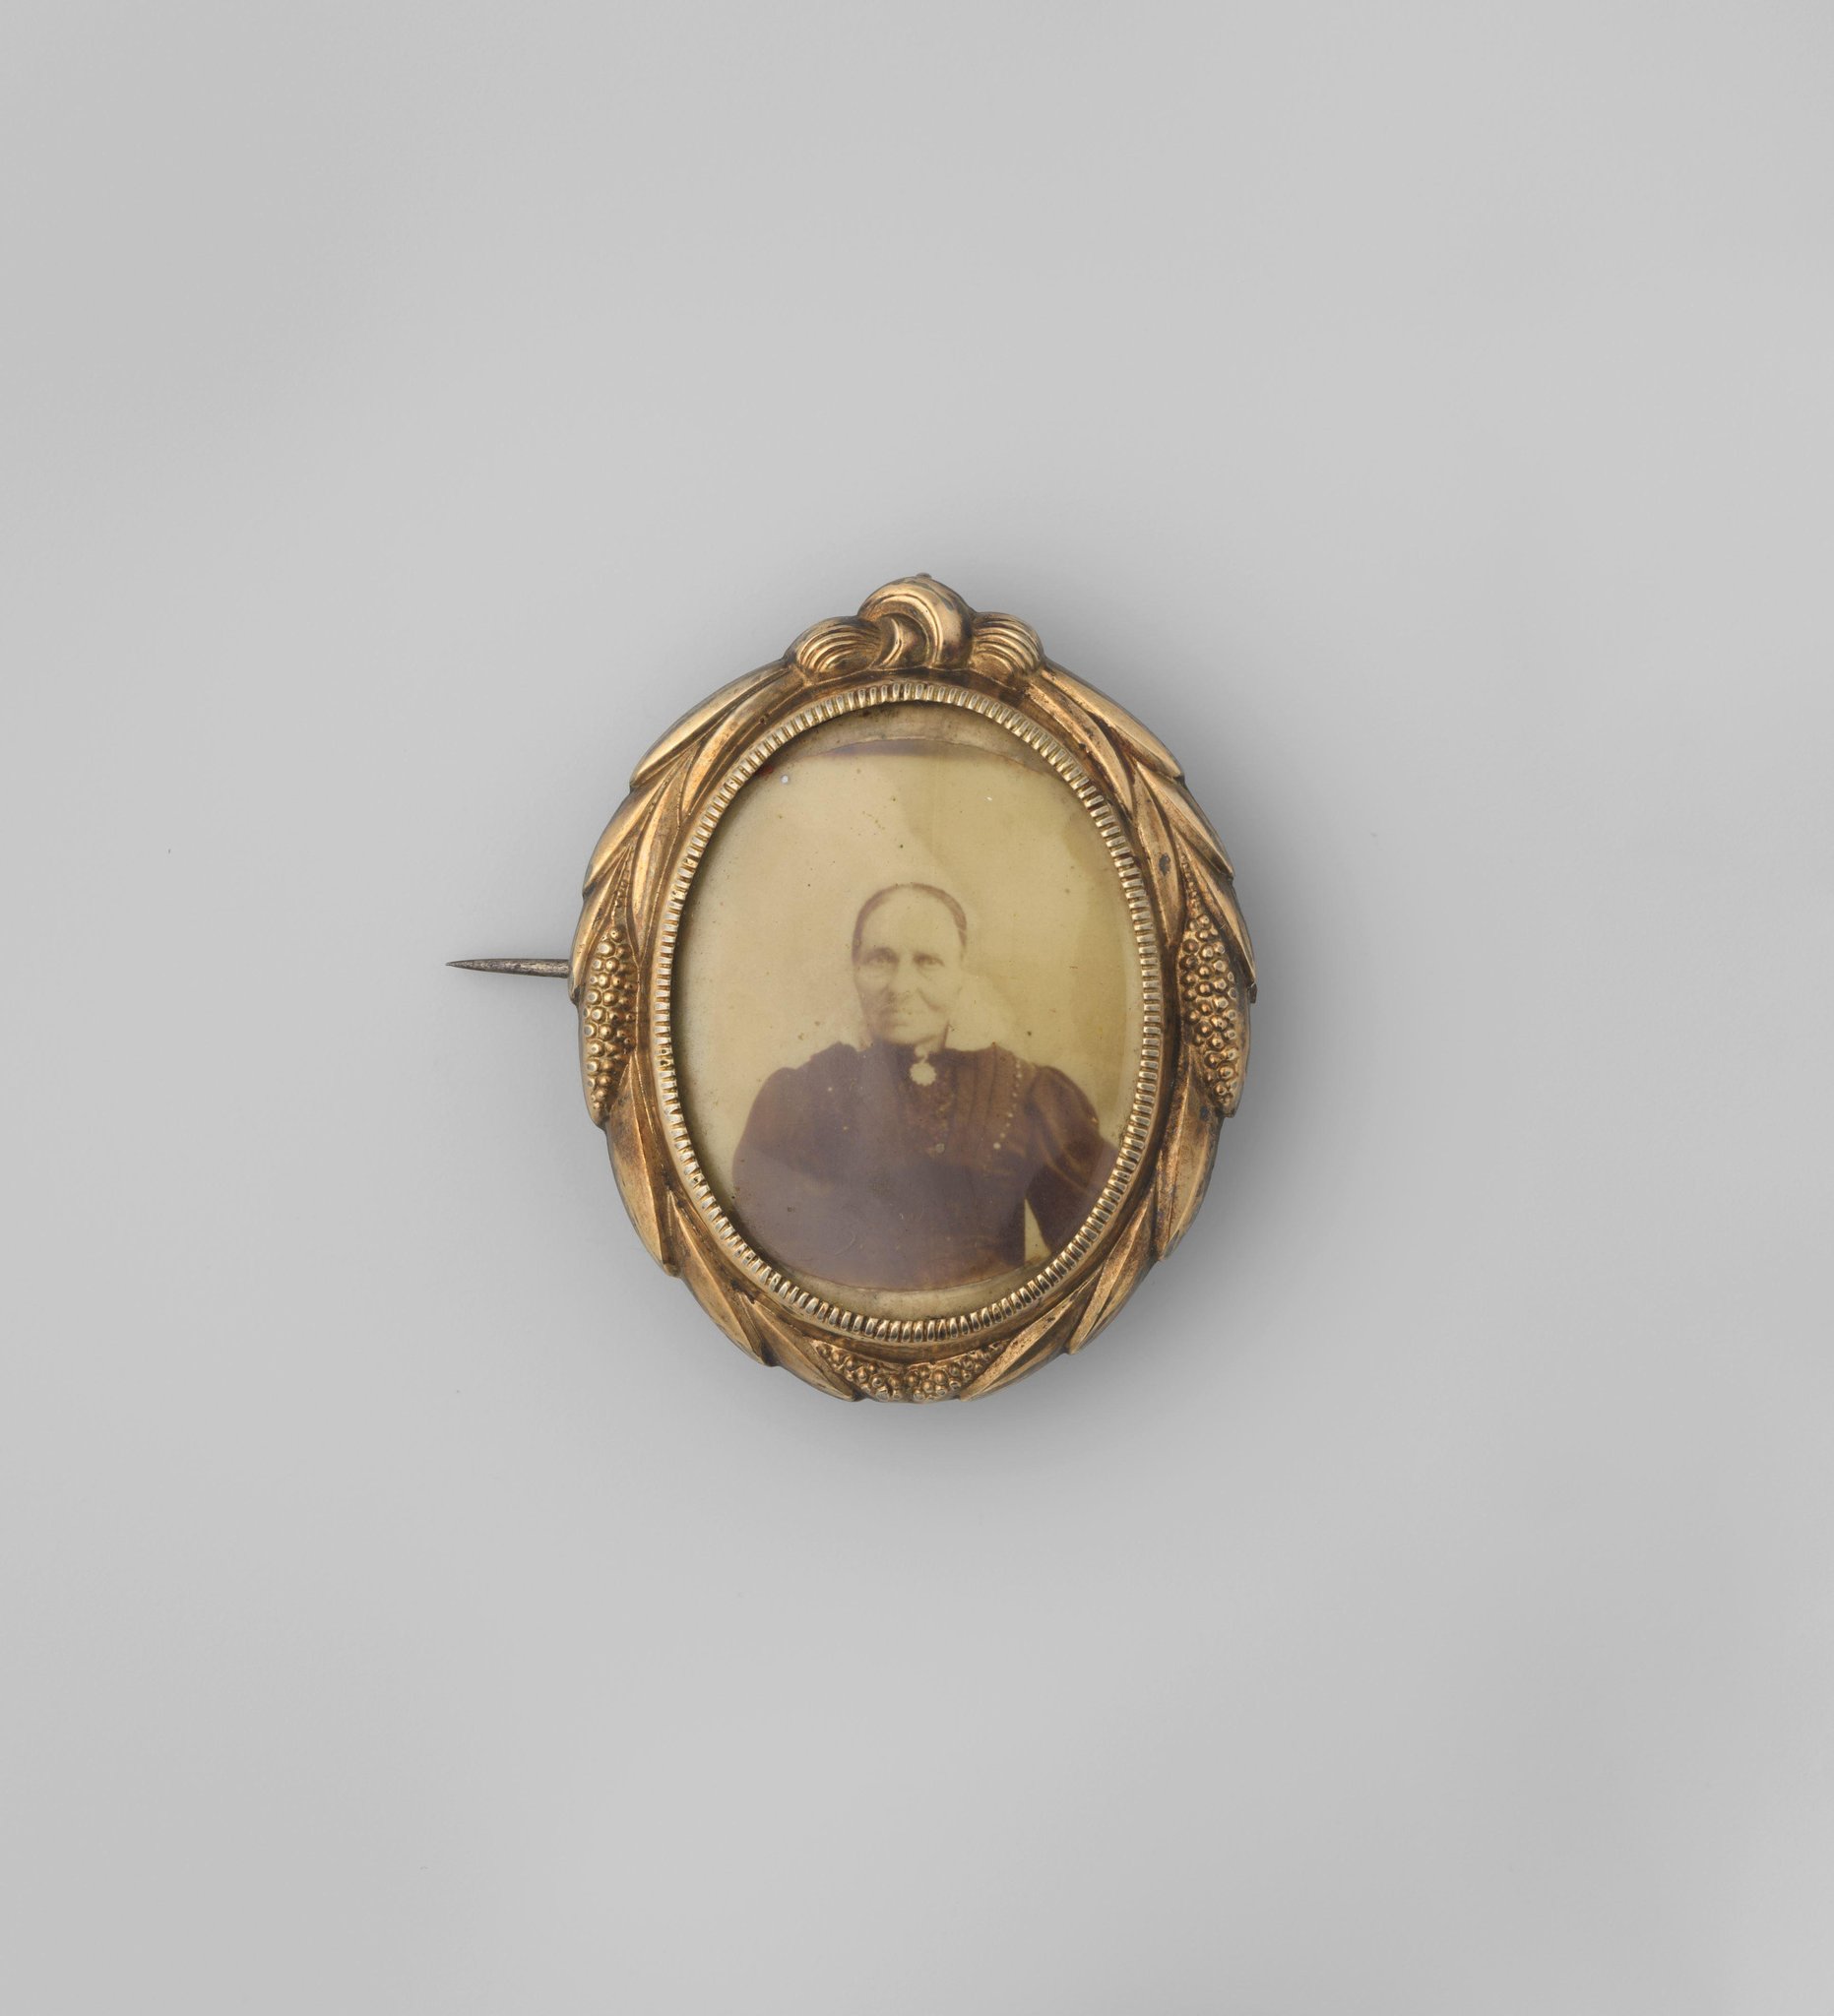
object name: brooch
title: Portret van een onbekende vrouw in klederdracht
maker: Anonymous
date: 1890-1910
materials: celluloid, hair, metal, paper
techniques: albumen print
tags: head-gear: cap, folk costume, regional costume, anonymous historical person portrayed - bb - woman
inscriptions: inscription: ‘[...] Haarlem jan 1970 f 25-’